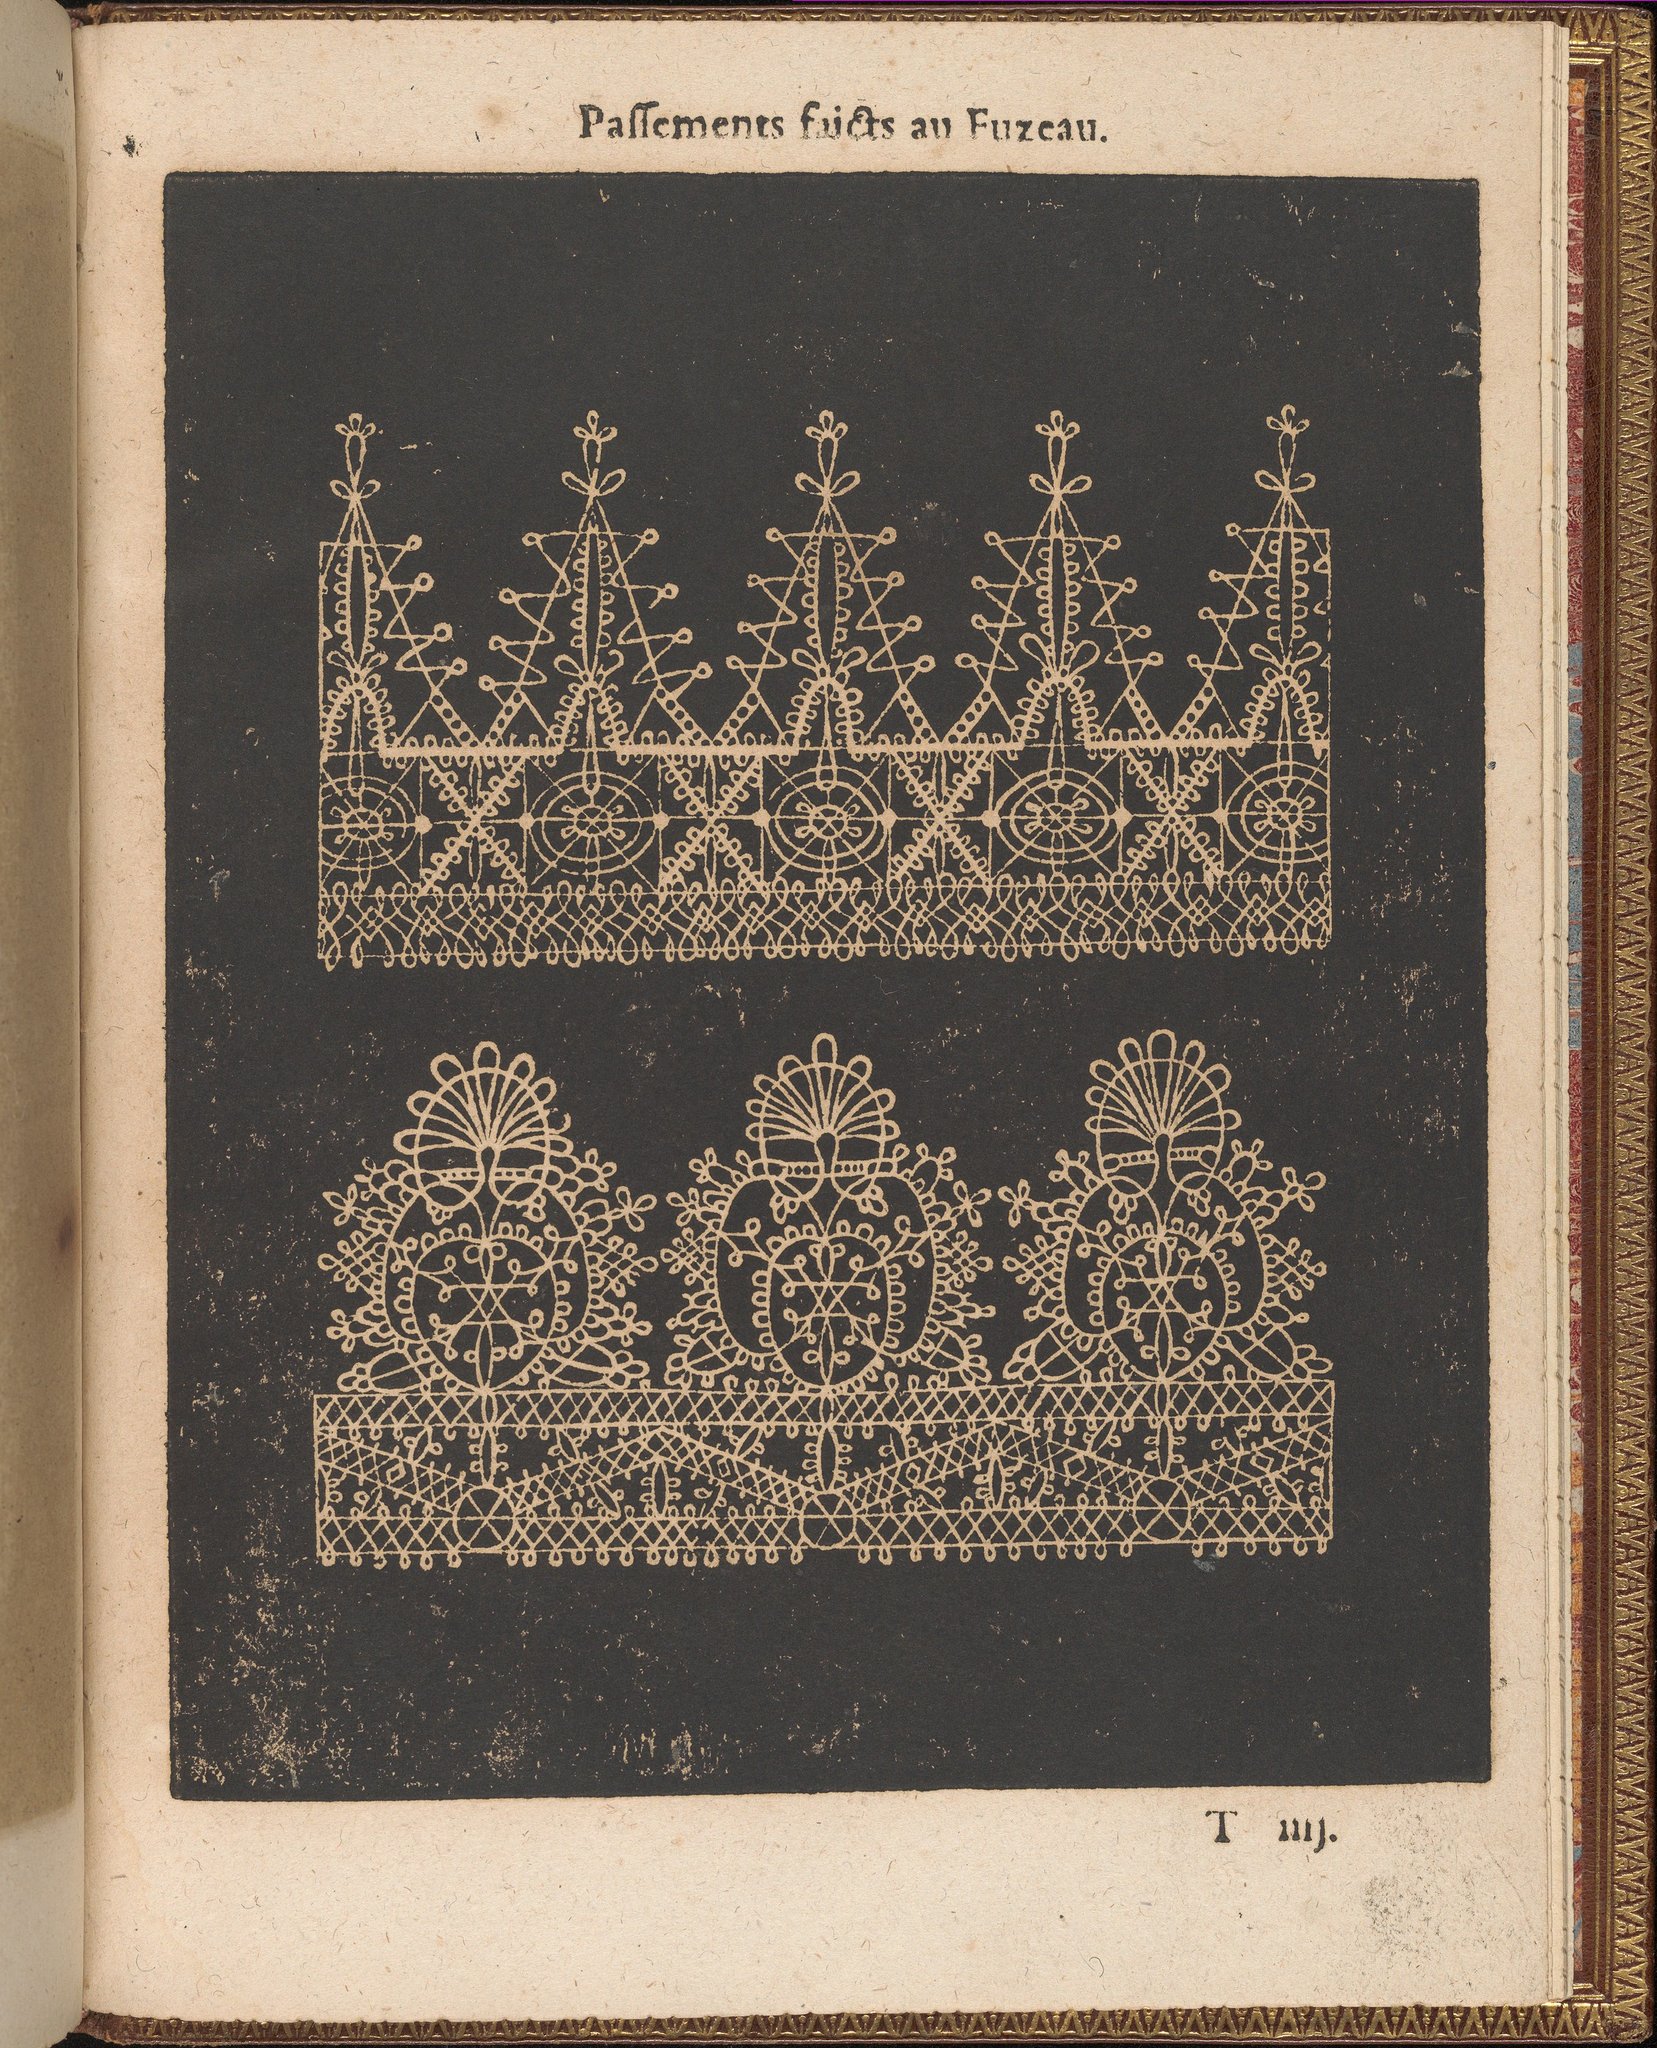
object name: book print ornament architecture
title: La Pratique de l'Aiguille, page 75 (recto)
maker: matthias mignerak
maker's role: author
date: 1605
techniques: woodcut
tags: ornament